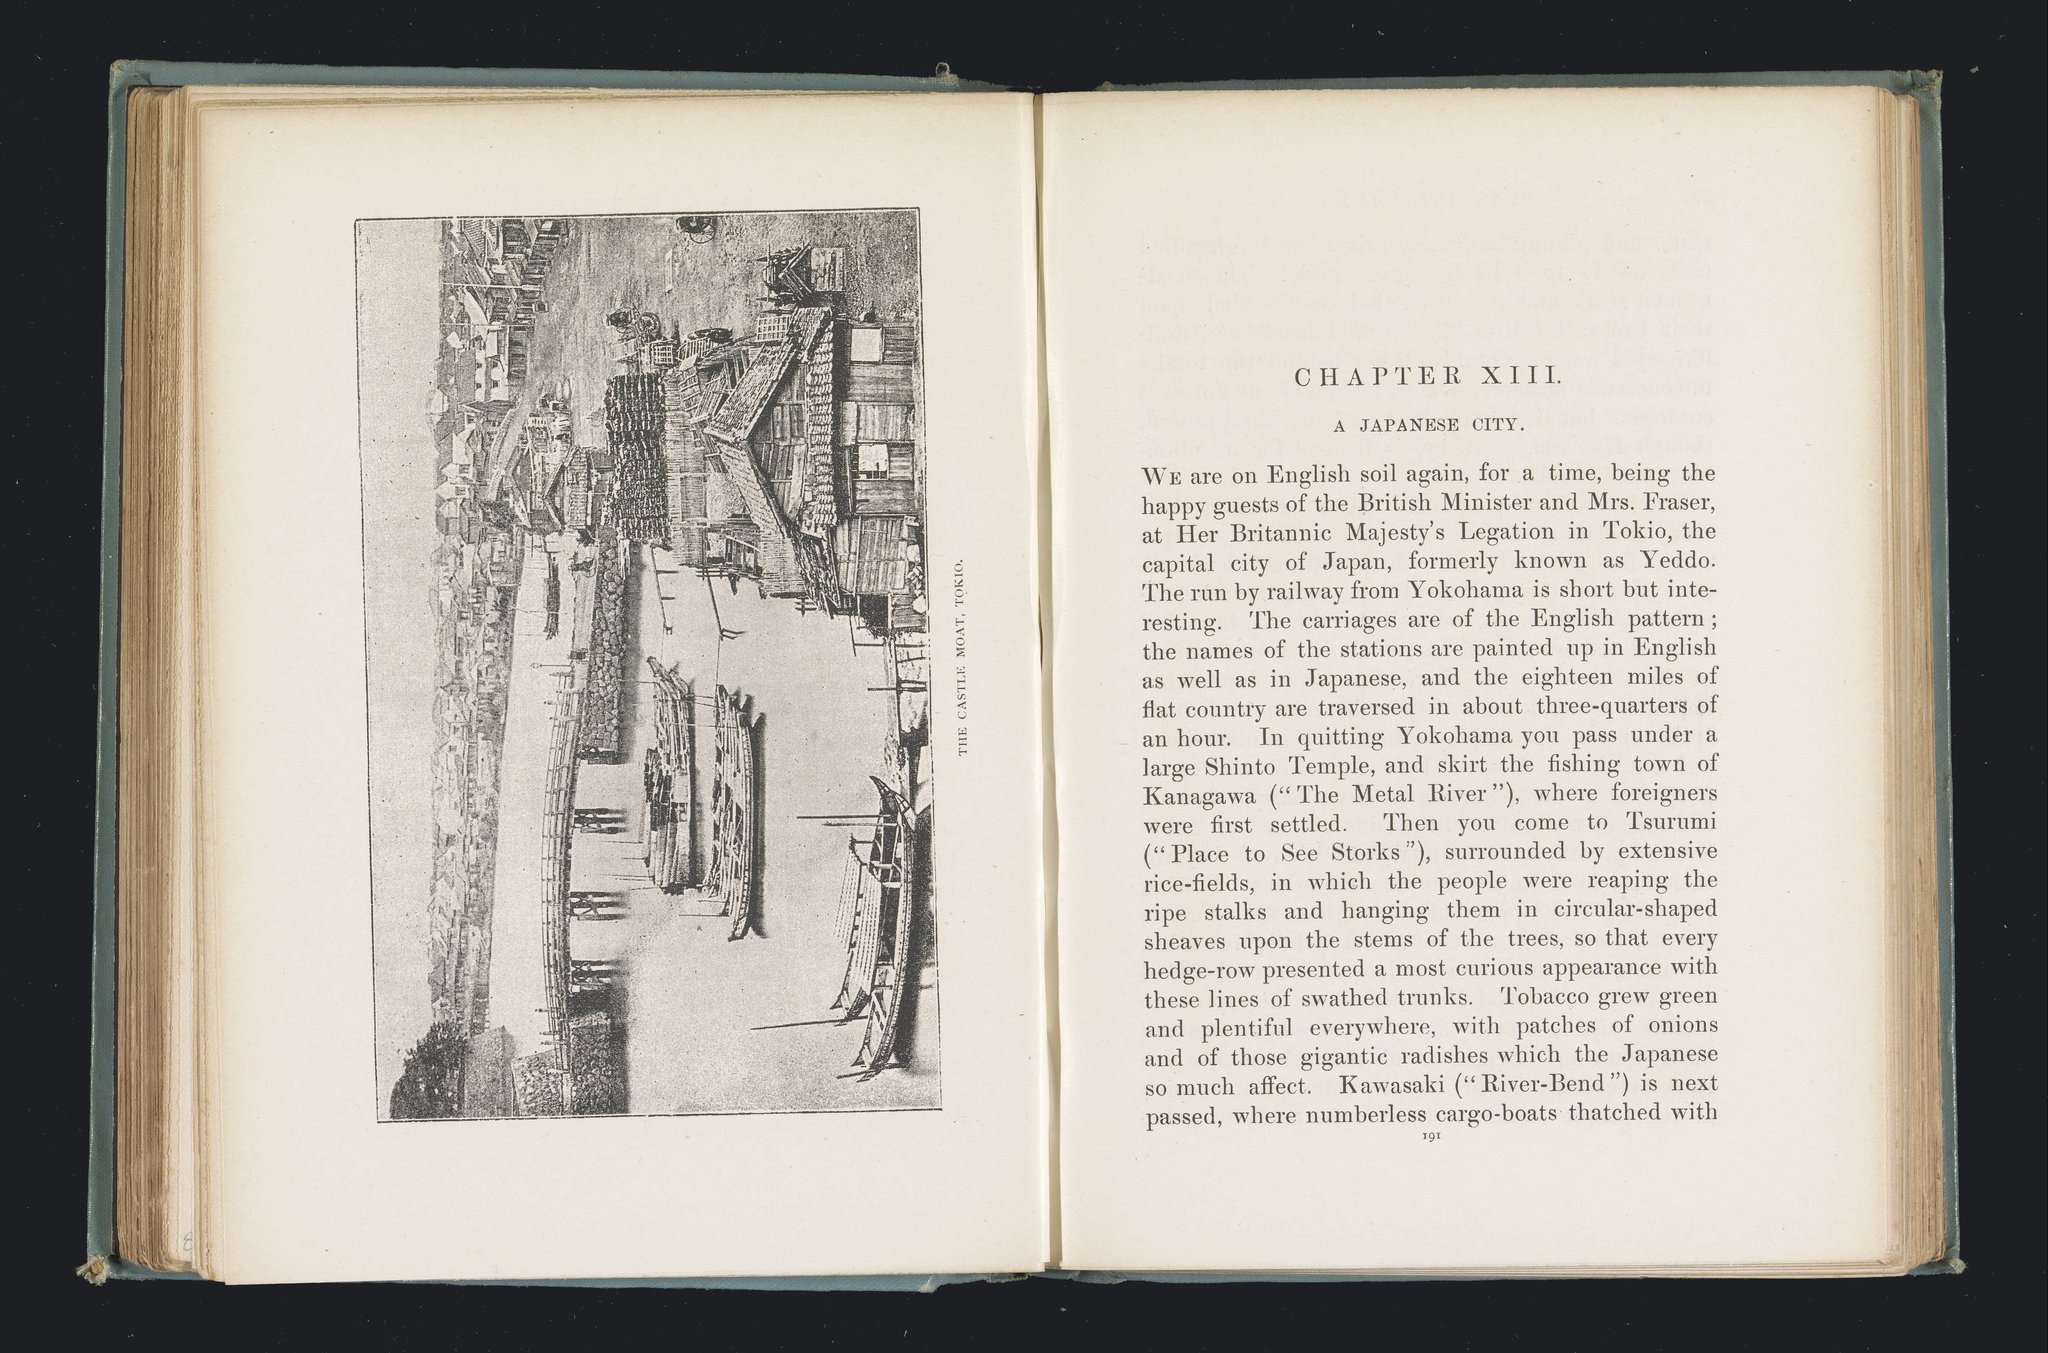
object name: page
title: The castle moat, Tokio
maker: Anonymous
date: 1882-1892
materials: paper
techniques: autotype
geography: tokyo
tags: moat ~ fortified city